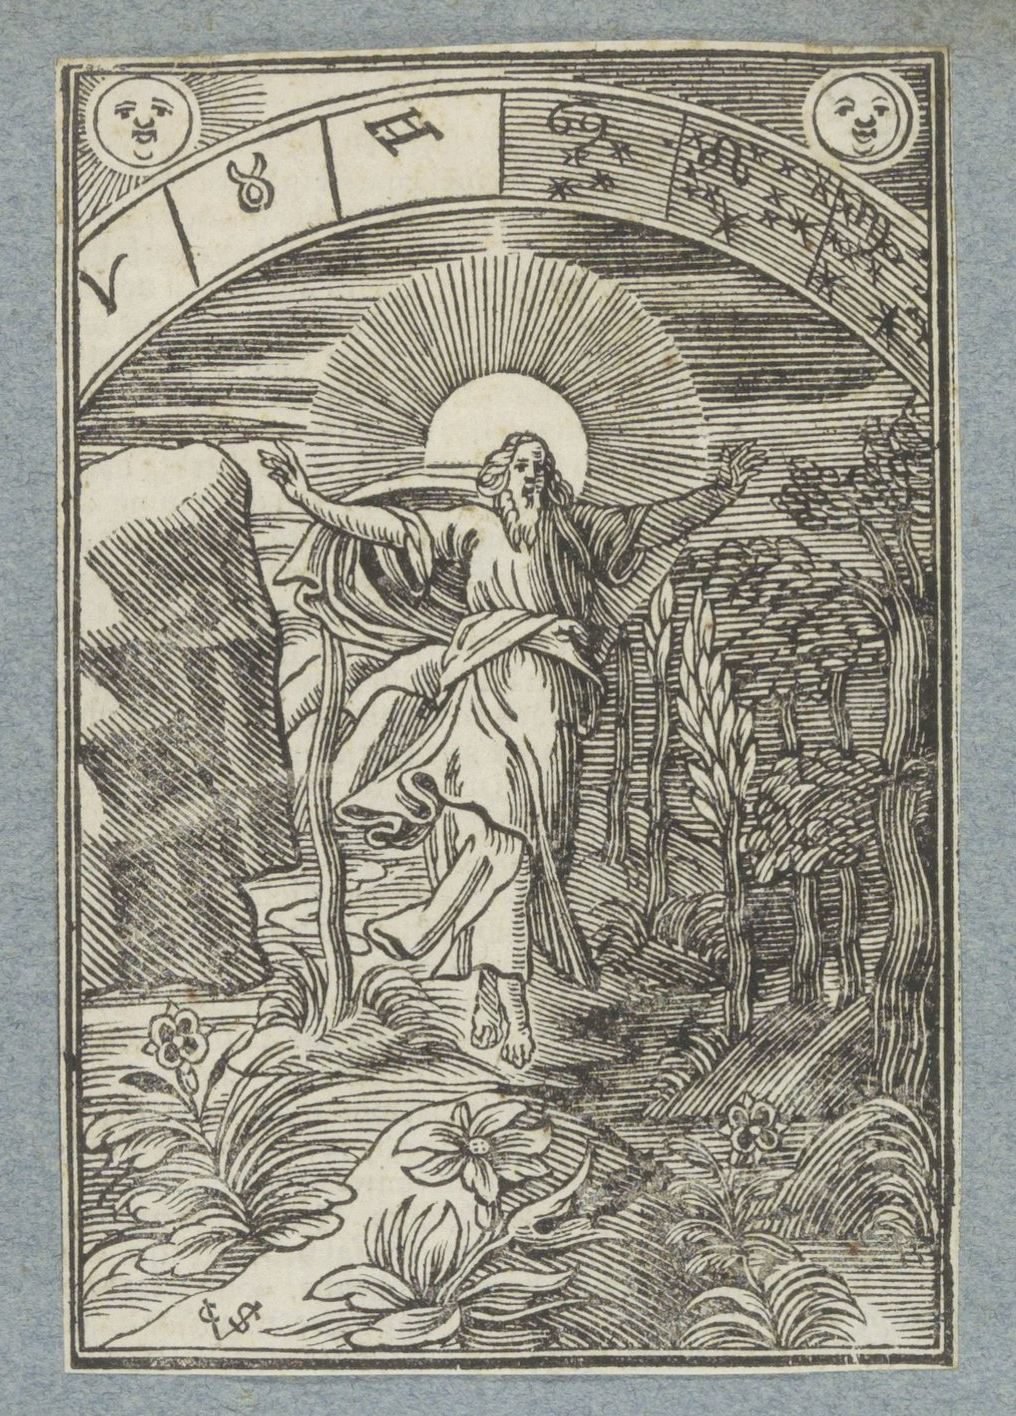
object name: album leaf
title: Vierde scheppingsdag: schepping van zon, maan en sterren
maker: pieter jacobsz. paets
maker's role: publisher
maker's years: 1587-1667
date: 1645-1646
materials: paper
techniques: letterpress printing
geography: amsterdam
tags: creation of sun, moon and stars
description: De prent werd gemaakt voor de uitgaven van P.J. Paets uit Amsterdam. Ze komt in ieder geval voor in: Bibels Tresoor ofte der zielen lusthof. Amsterdam, P.J. Paets, 1646. Mogelijk ook in: Historien ende Prophetien. [Amsterdam], P.J. Paets, 1645.